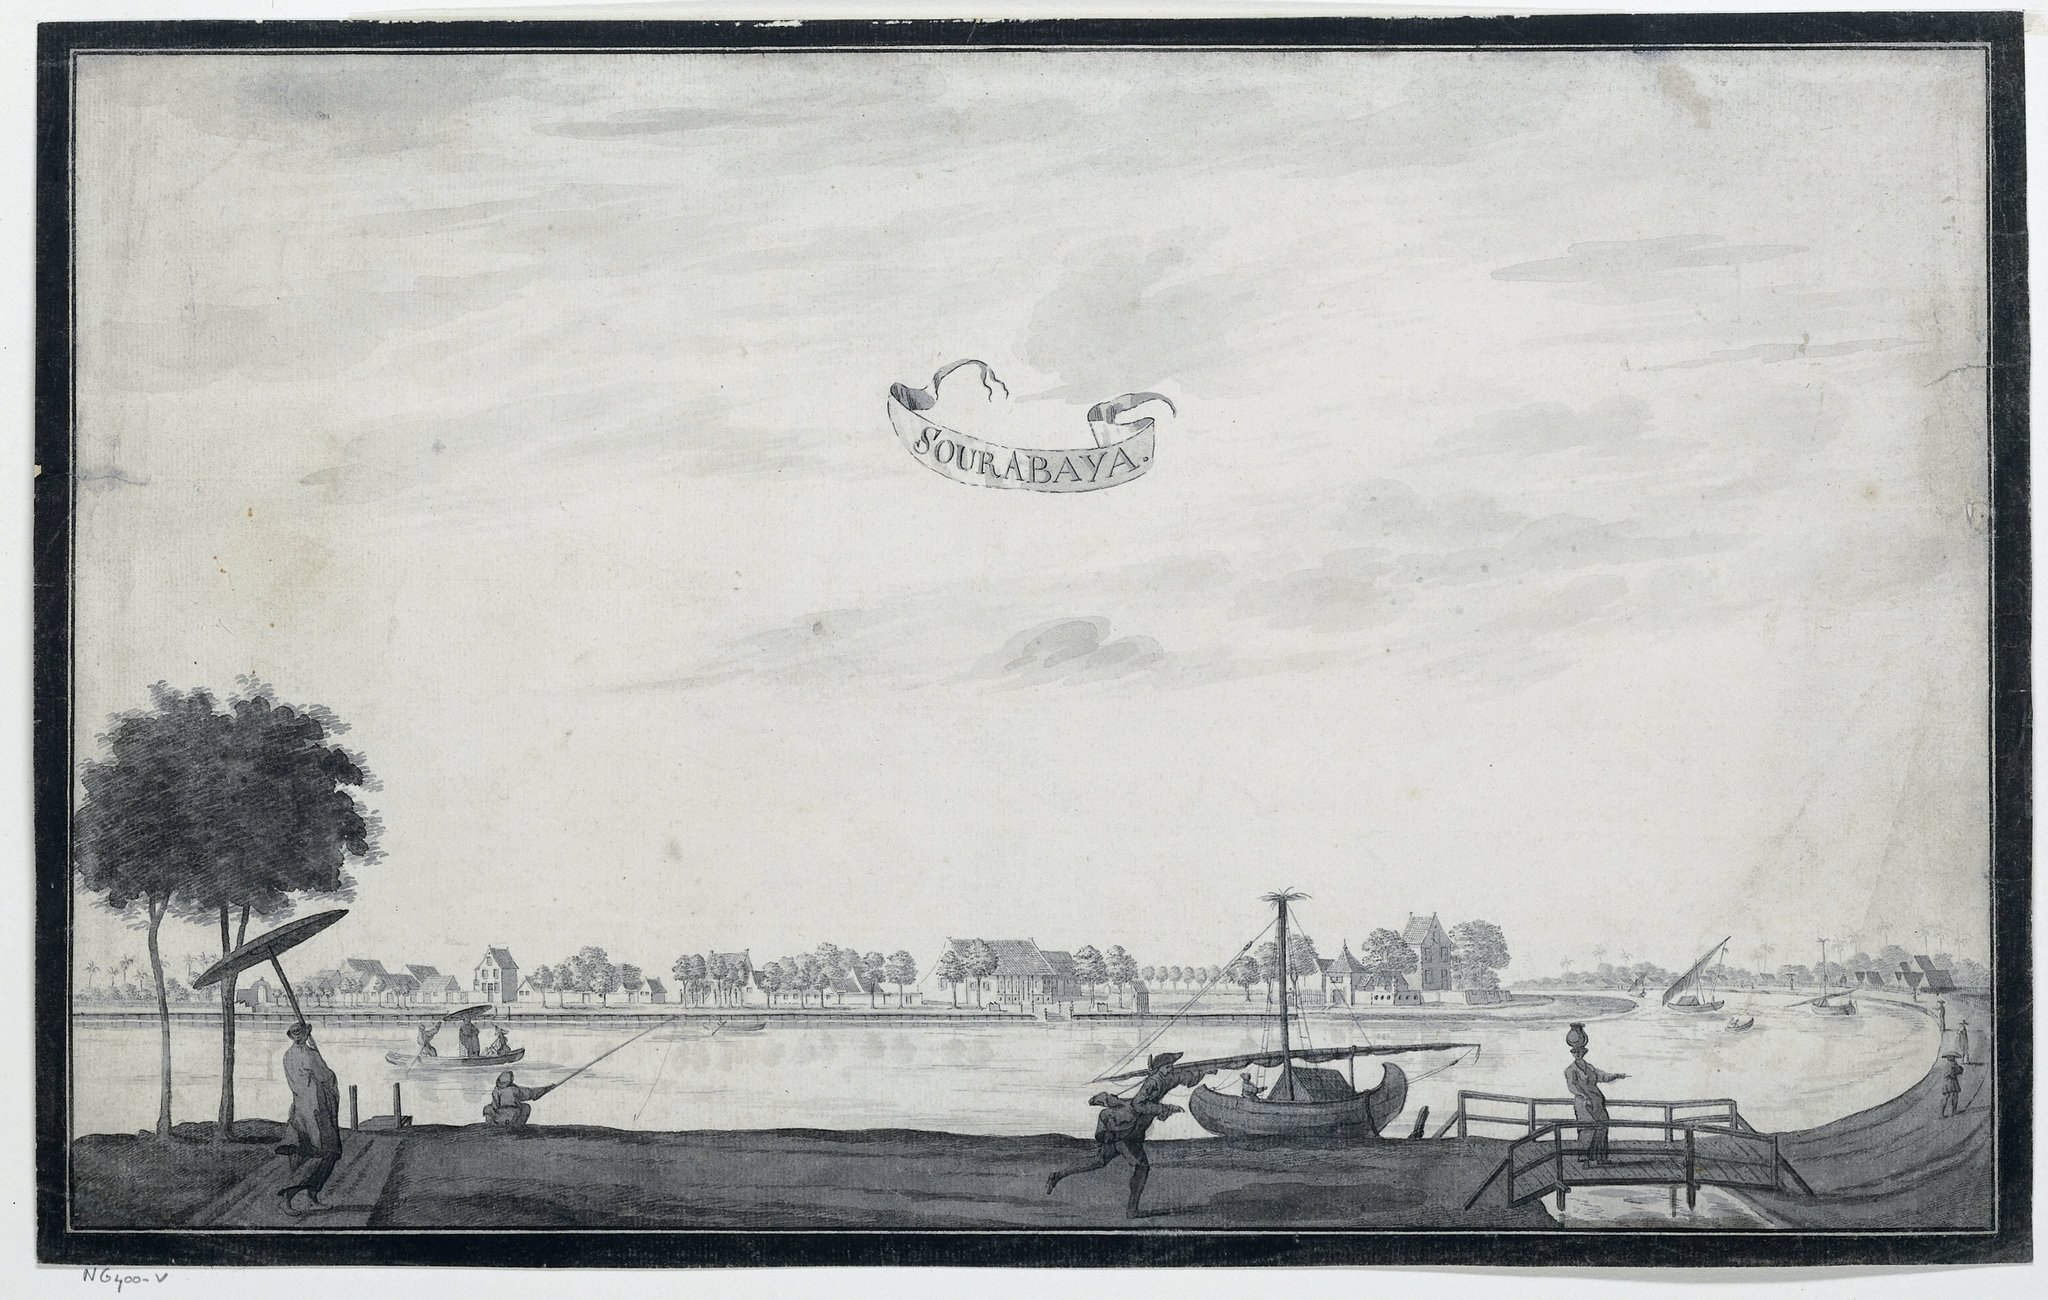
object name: drawing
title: Sourabaya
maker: a. de nelly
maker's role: draughtsman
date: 1750-1800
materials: ink, paper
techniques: brush, pen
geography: surabaya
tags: landscapes in tropical and sub-tropical regions, river (+ landscape with figures, staffage), java, surabaya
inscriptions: inscription: ‘SOURABAYA’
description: Gezicht op Soerabaja. Op de voorgrond weg langs een rivier met bruggetje over zijwatertje. Linksonder twee bomen en figuur met parasol. Op de rivier enige boten en aan de overkant huizen en bomen. In de lucht opschrift in banderol.